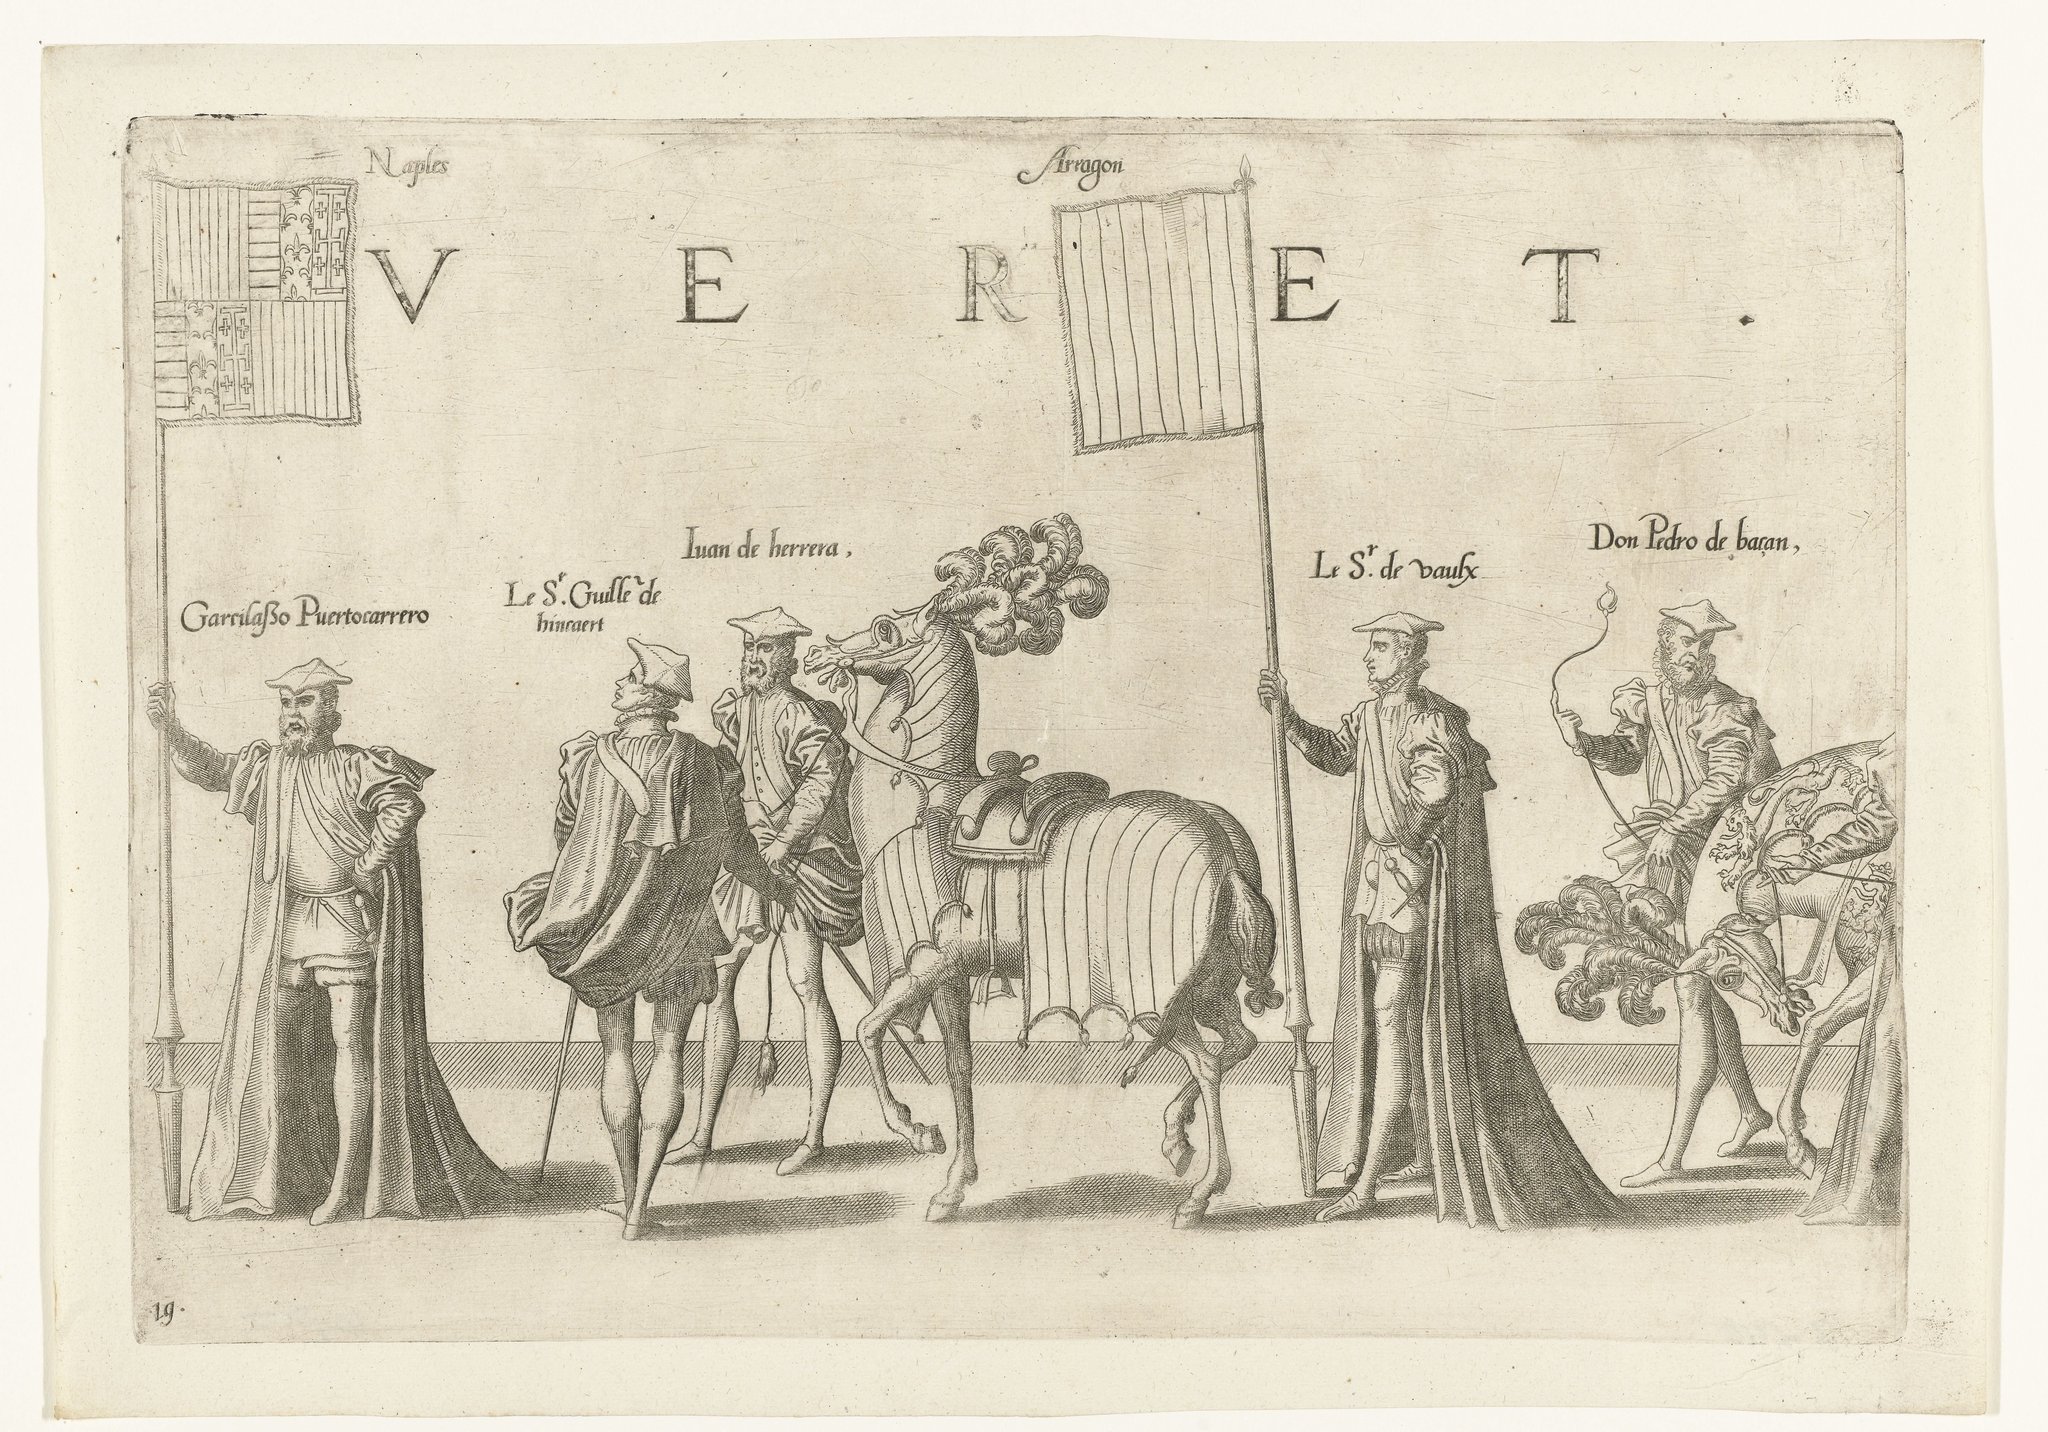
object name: print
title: Deel van de optocht, nr. 19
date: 1559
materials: paper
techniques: engraving, etching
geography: southern netherlands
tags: ghent, charles v (holy roman emperor and king of spain), cortege, funeral procession, brussels, naples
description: Vijf deelnemers aan de optocht, paarden en de vaandels met de wapens van Napels en Aragon. Onderdeel van de prentreeks van de Begrafenisoptocht van keizer Karel V op 29 december 1558 te Brussel.